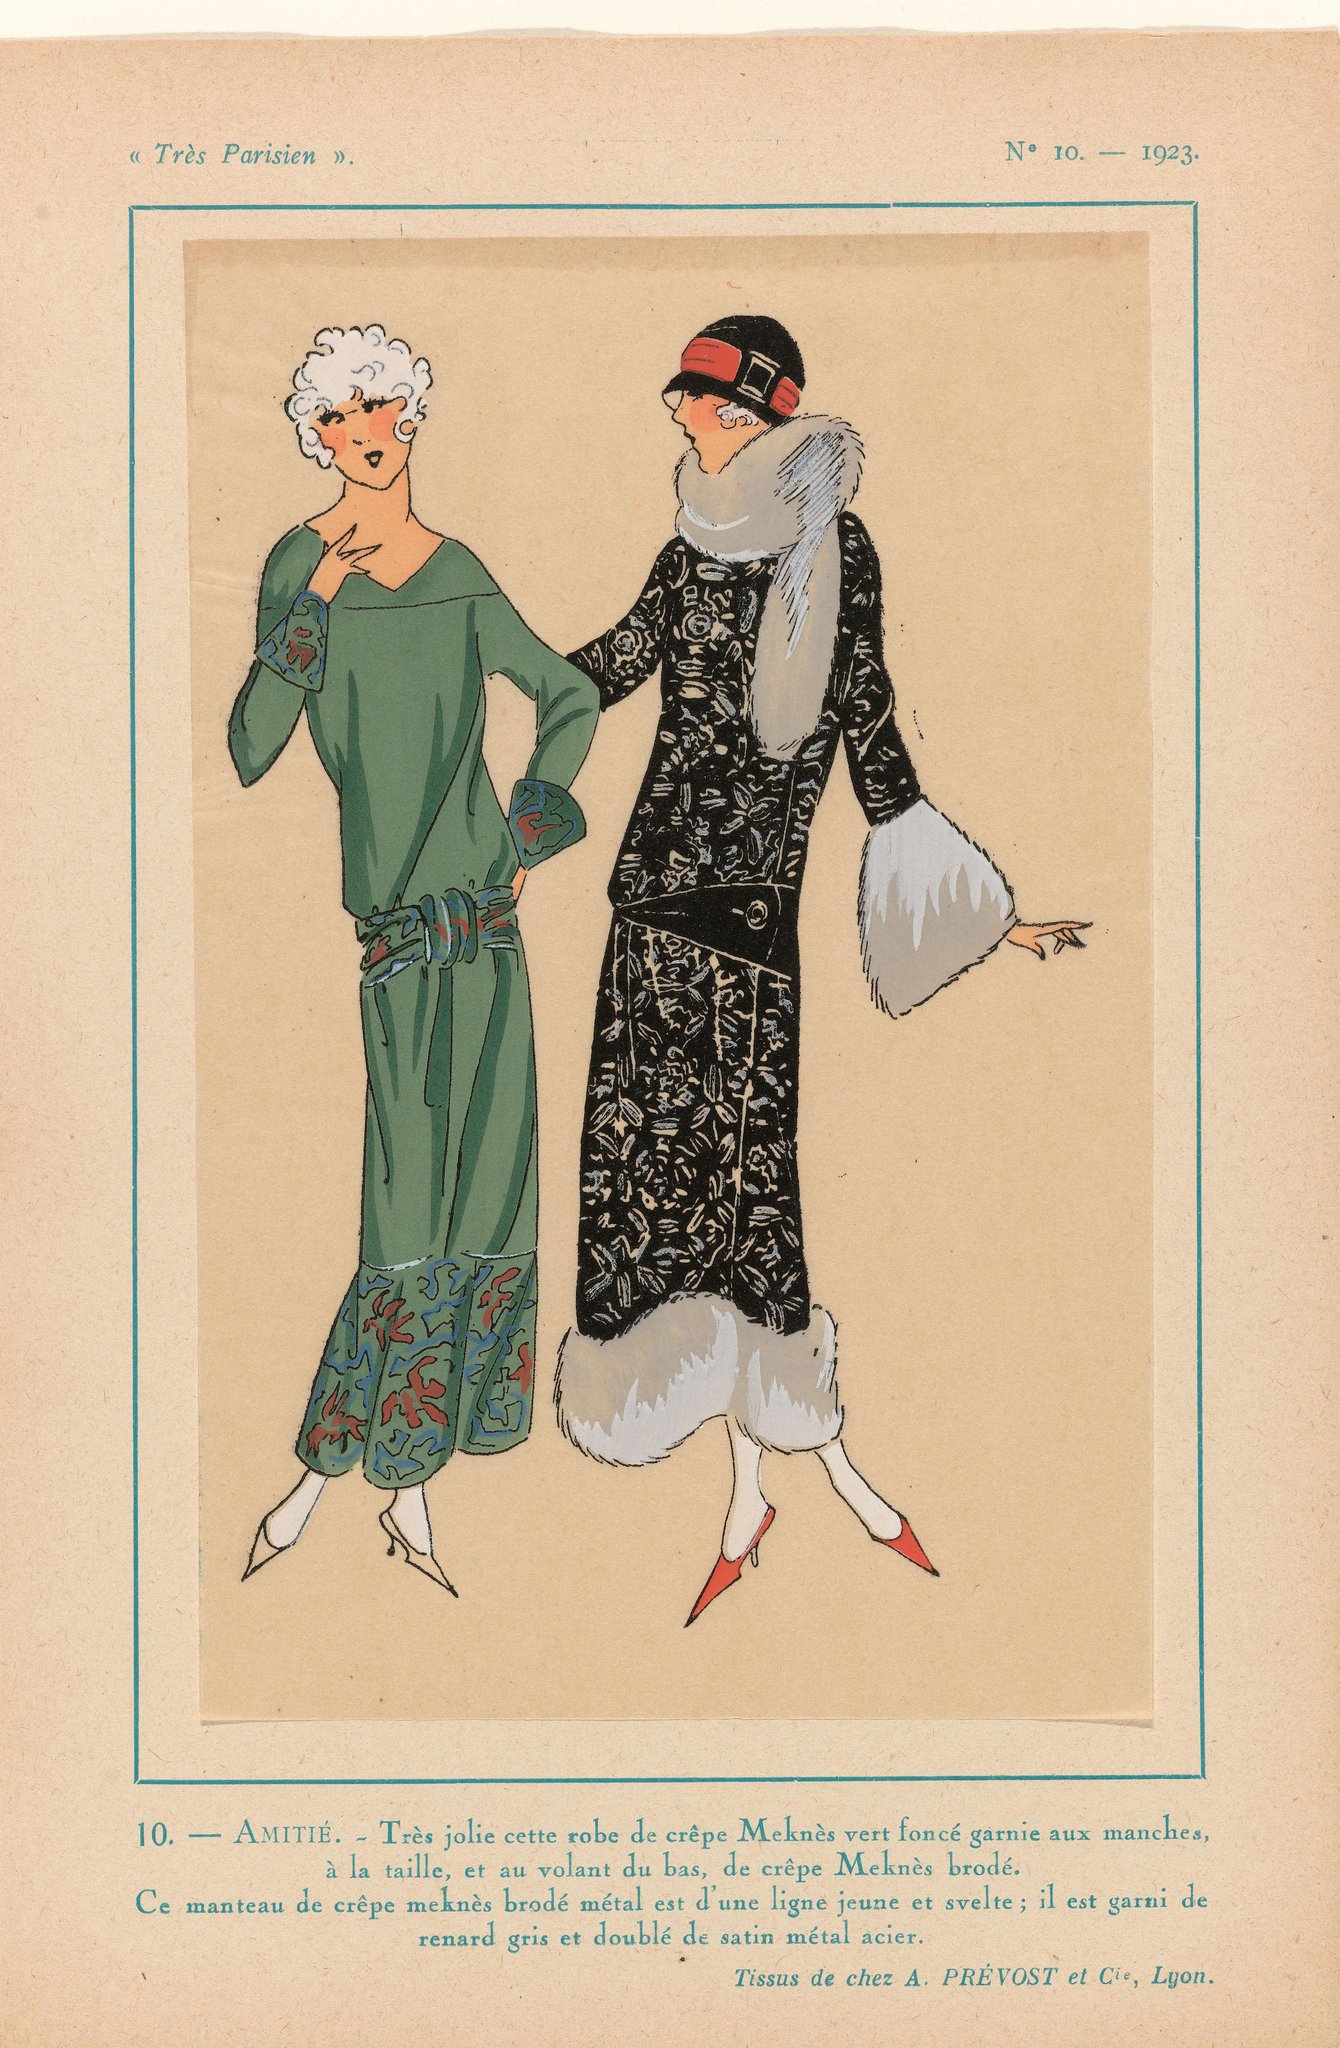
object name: fashion print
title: Très Parisien, 1923, No 10: 10. - AMITIÉ. - Très jolie cette robe...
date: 1923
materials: paper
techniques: hand coloring, letterpress printing, lithography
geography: lyon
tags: embroidery (ornamentation) (+ women's clothes), border, ribbon, braid (+ fur used for clothes), coat (+ women's clothes), fashion plates, dress, gown (+ women's clothes), neck-gear: collar (+ fur used for clothes)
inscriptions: title: ‘Très Parisien / No 10. - 1923’, caption: ‘10. - AMITIÉ. - Très jolie cette robe de crêpe Meknès vert foncé garnie aux manches, à la taille, et au volant du bas, de crêpe Meknès brodé. Ce manteau de crêpe meknès brodé métal est d'une ligne jeune et svelte; il est garni de renard gris et doublé de satin métal acier. / Tissus de chez A. PRÉVOST et Cie, Lyon.’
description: Jurk van donkergroene crêpe Meknès; de mouwen, taille en volant aan de onderkant gegarneerd met geborduurde crêpe Meknès. Mantel van 'crêpe meknès brodé métal' gegarneerd met grijs vossenbont en gevoerd met 'satin métal acier'. Stoffen van A. Prévost et Cie. Accessoires: cloche (pothoed), pumps. Prent uit het modetijdschrift Très Parisien (1920-1936).